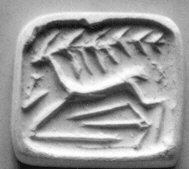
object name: stamp seal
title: Gable seal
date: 4000-3600 BCE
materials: stone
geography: mesopotamia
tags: animals